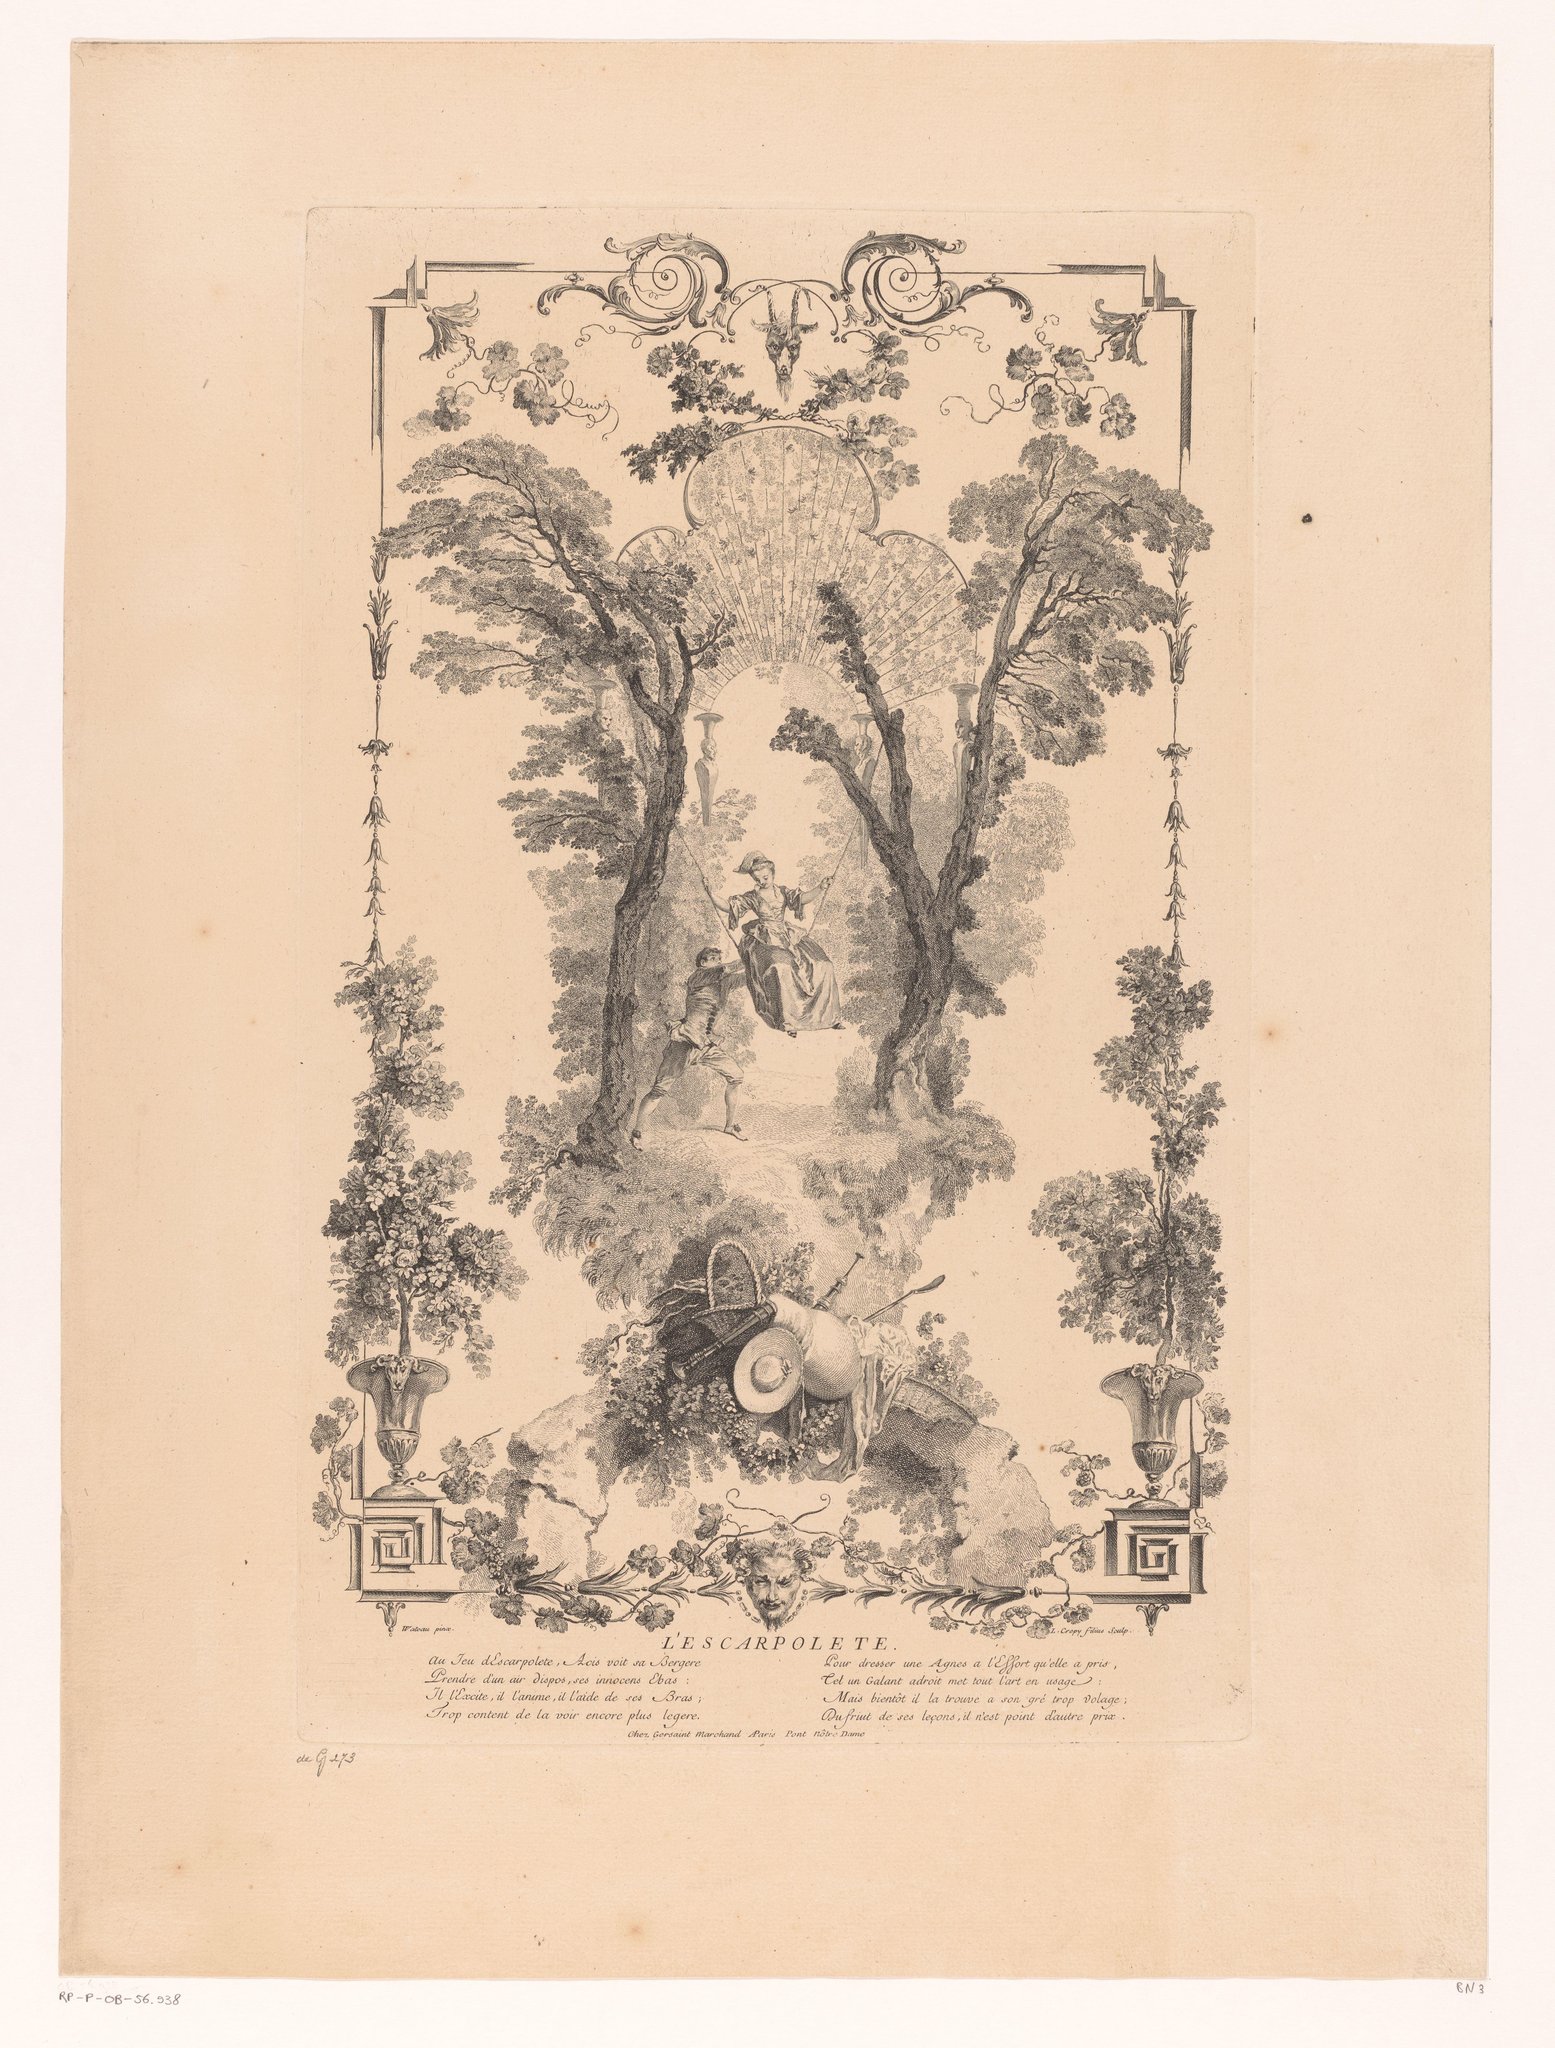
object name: print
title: Oeuvre van Antoine Watteau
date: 1727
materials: paper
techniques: etching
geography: paris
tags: panelling, swing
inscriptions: collector's mark: Lugt 2228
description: Maakt deel uit van een serie van 271 platen naar werken door Watteau, verdeeld over drie delen, gecoördineerd door Jean de Jullienne en uitgegeven in Parijs in 1735. Sommige platen werden reeds tijdens Watteau's leven gemaakt. Dit betreft plaat 68. Het schilderij door Watteau bevindt zich in het Kunstmuseum Sinebrychoff te Helsinki, inv.nr. A II 1413.